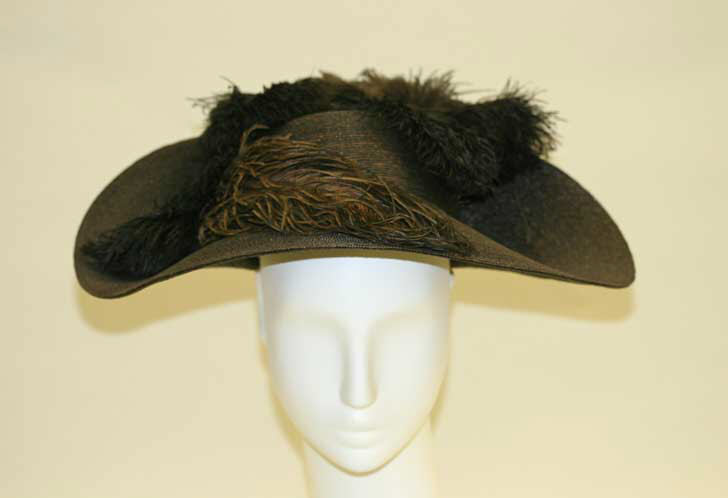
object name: hat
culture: american or european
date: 1890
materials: feather, fiber